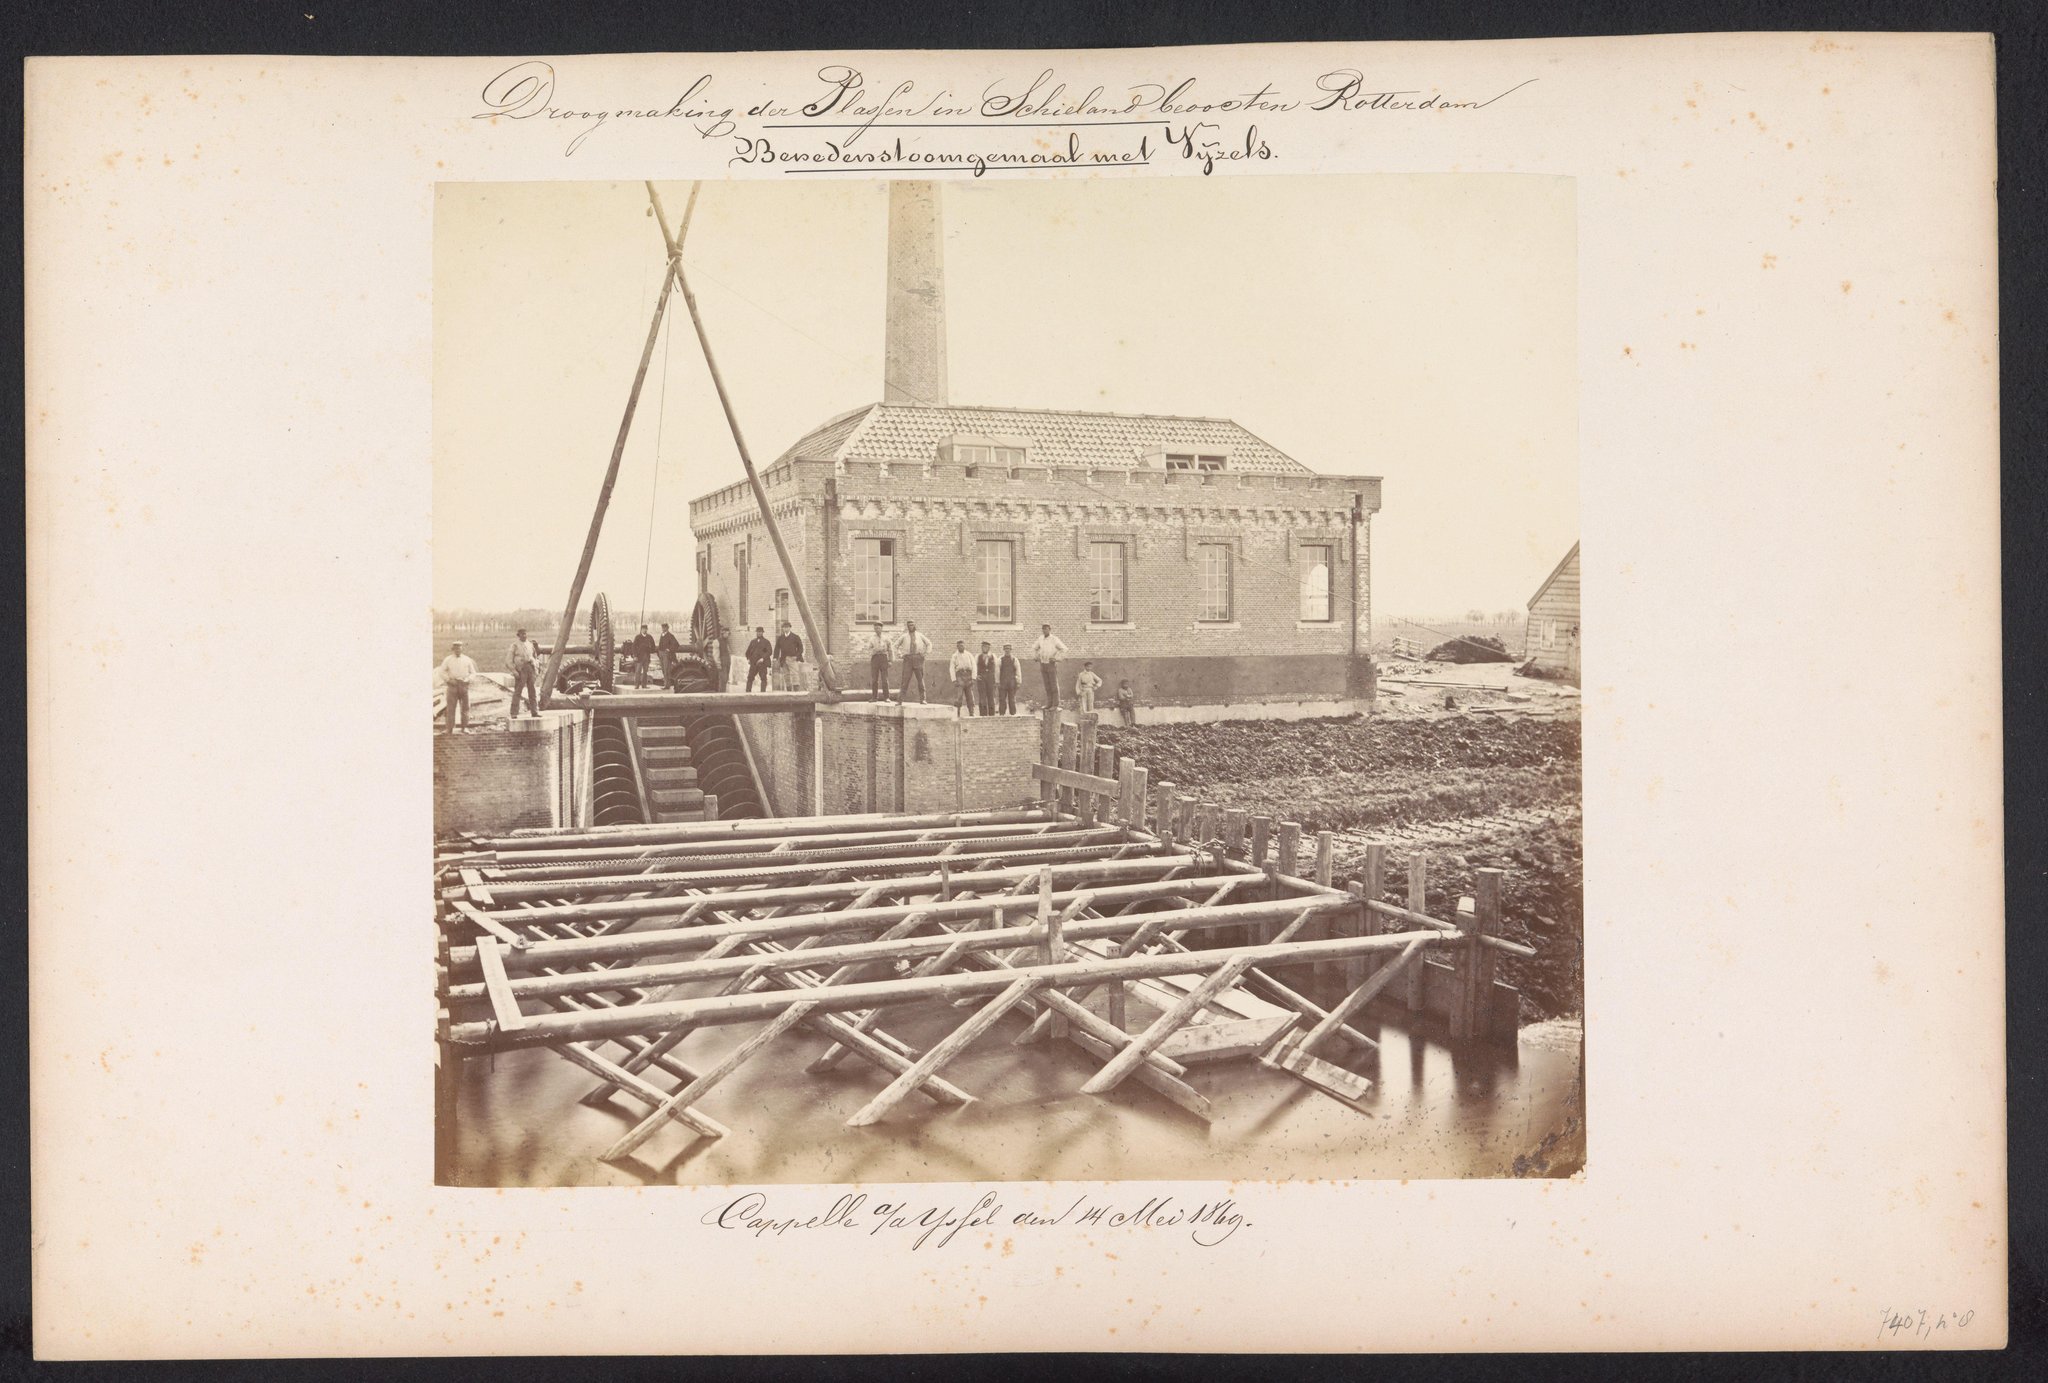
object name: photograph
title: Benedenstoomgemaal met Vijzels / Cappelle aan den IJssel den 14 Mei 1869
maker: jacobus van gorkom (jr.)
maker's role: print maker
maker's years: 1827-1880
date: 1869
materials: cardboard, photographic support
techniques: albumen print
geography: rotterdam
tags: draining for land reclamation, pumping installation, pumping-engine (~ polder)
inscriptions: date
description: Stoomgemaal te Capelle aan den IJssel op 14 mei 1869. Onderdeel van een serie van tien foto's van de droogmaking in 1867-1869 van de plassen in Schieland ten oosten van Rotterdam.